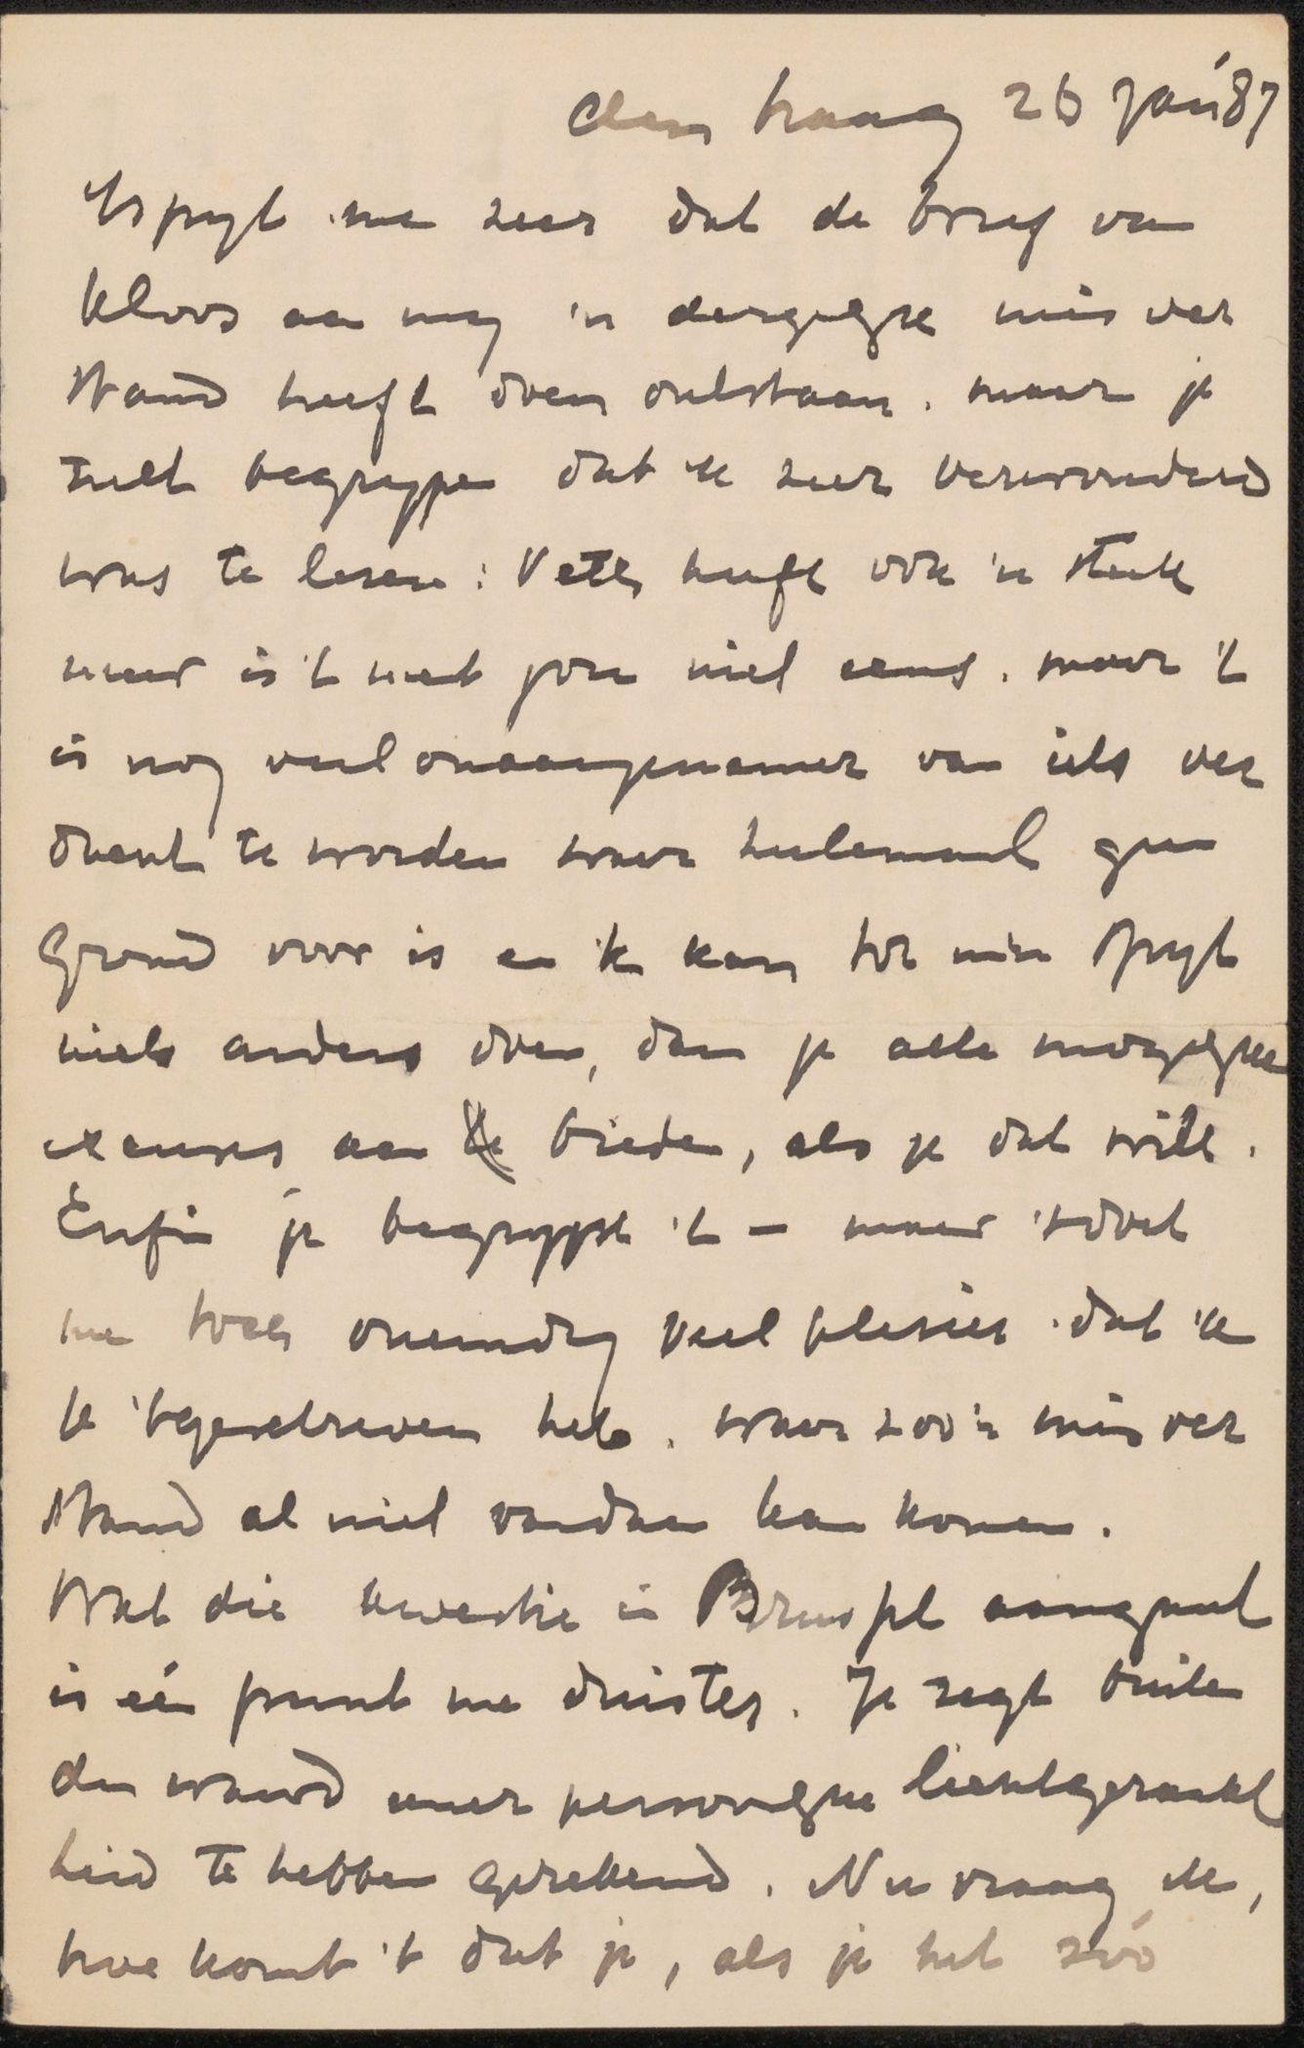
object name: letter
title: Brief aan Jan Veth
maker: willem witsen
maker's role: draughtsman, painter, print maker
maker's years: 1860-1923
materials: ink, paper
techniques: pen, writing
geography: the hague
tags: print maker, draughtsman, bernardus johannes blommers, dordrecht, designer, jan veth, arnhem, anton mauve, den bosch, antoon derkinderen, willem kloos, diseases, money, printed matter, brussels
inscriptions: collector's mark: ‘RPK’